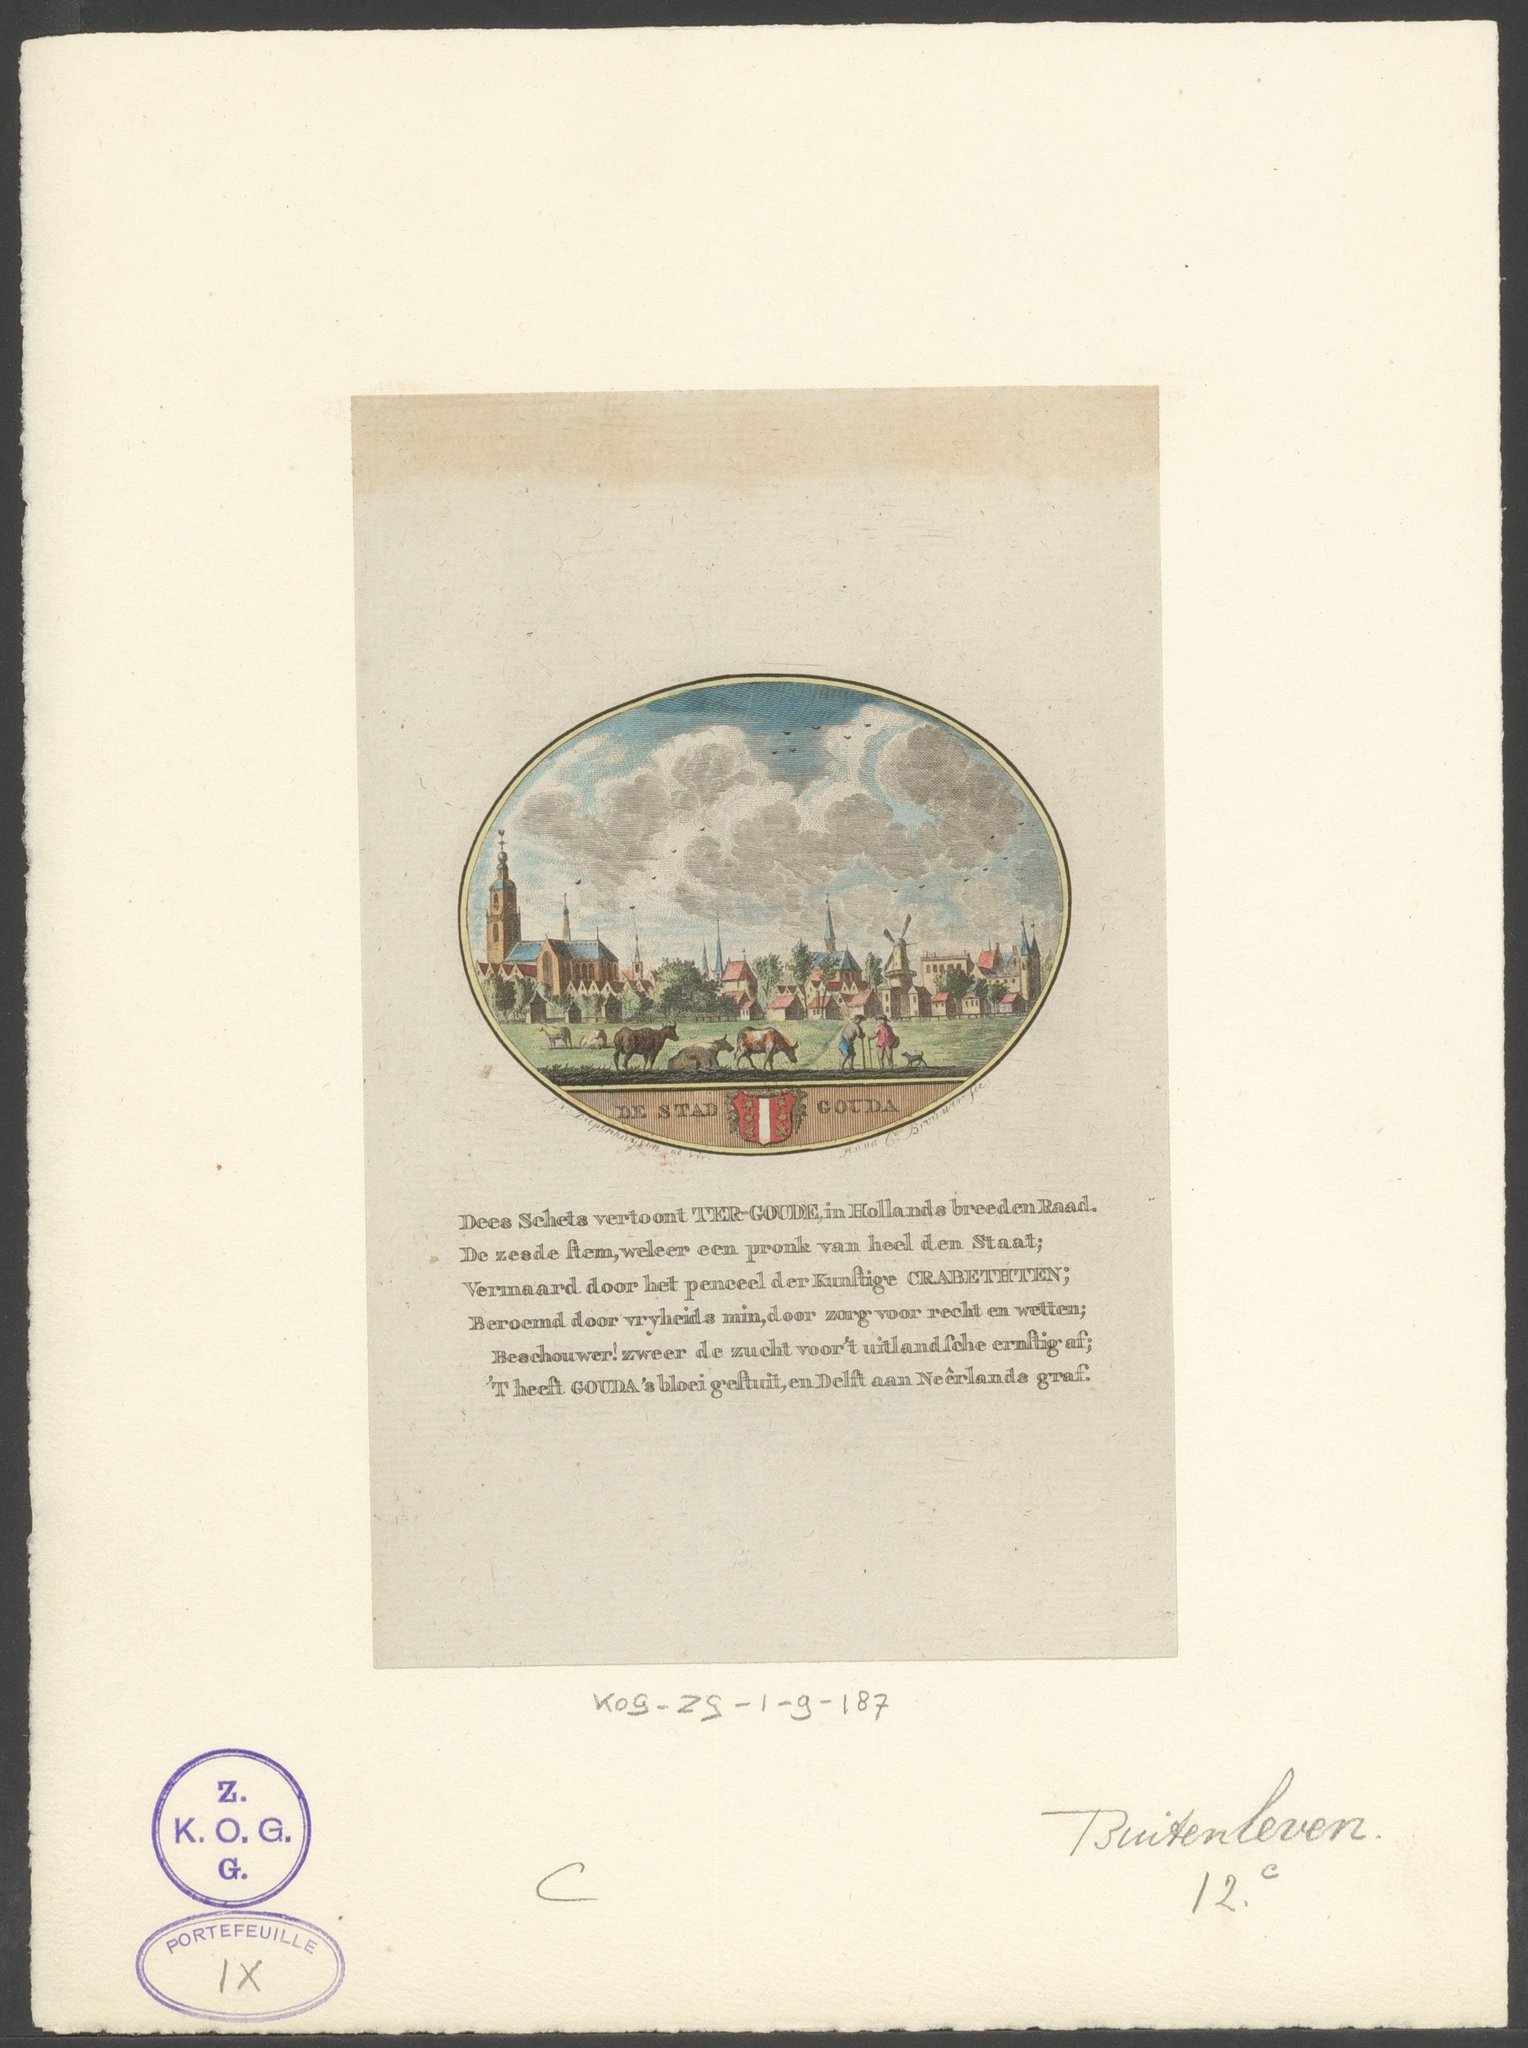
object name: print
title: De stad Gouda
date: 1791-1793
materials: paper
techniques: etching, hand coloring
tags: city-view, and landscape with man-made constructions, cow, church (exterior), gouda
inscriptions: collector's mark: Lugt 1641, stamp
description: Gezicht op Gouda, met vee op de voorgrond. Onderaan een zesregelig vers. Onderwerpsrubrieken binnen de Atlas Zeden en Gewoonten: Handel, nijverheid en verkeer, Buitenleven.